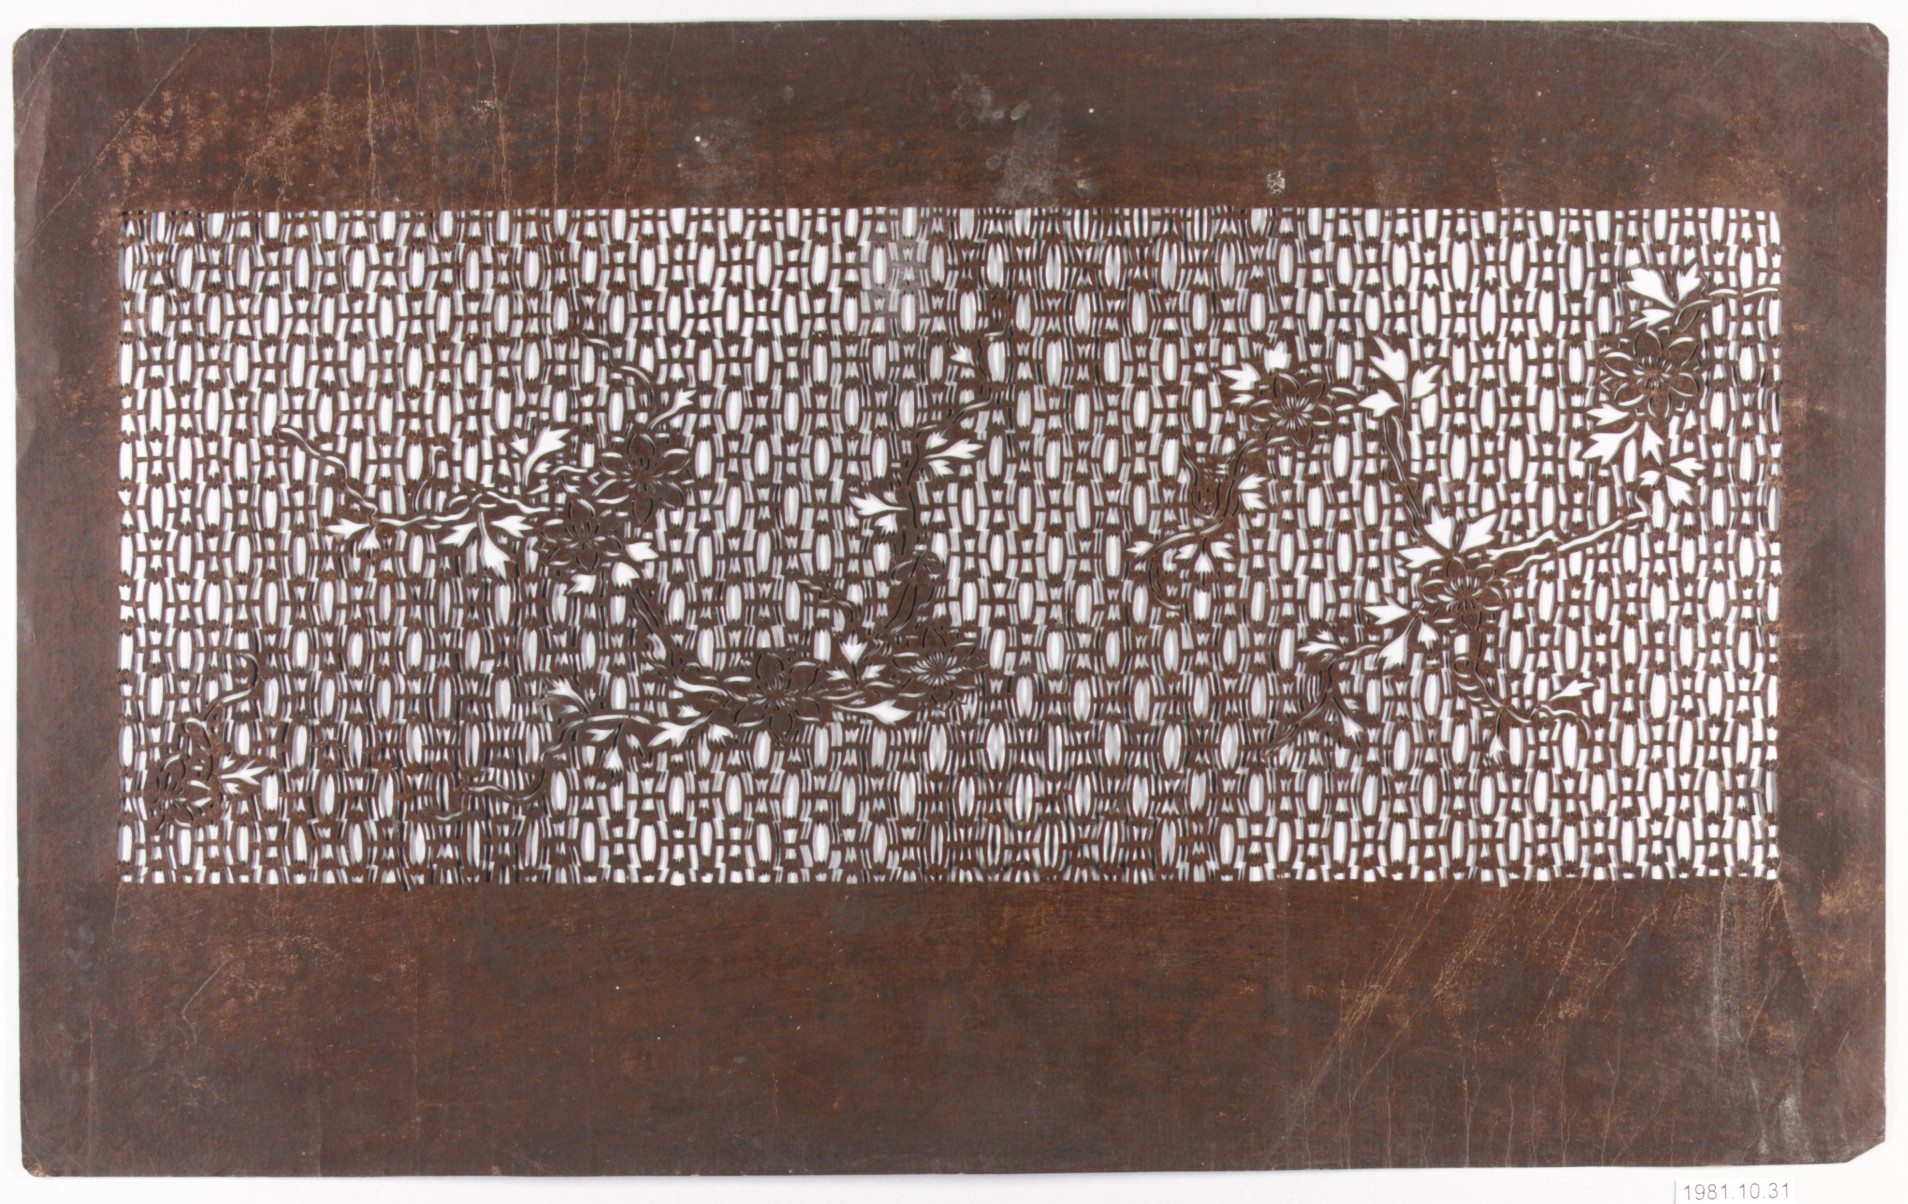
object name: stencil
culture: japanese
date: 1801-1900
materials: paper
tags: flowers